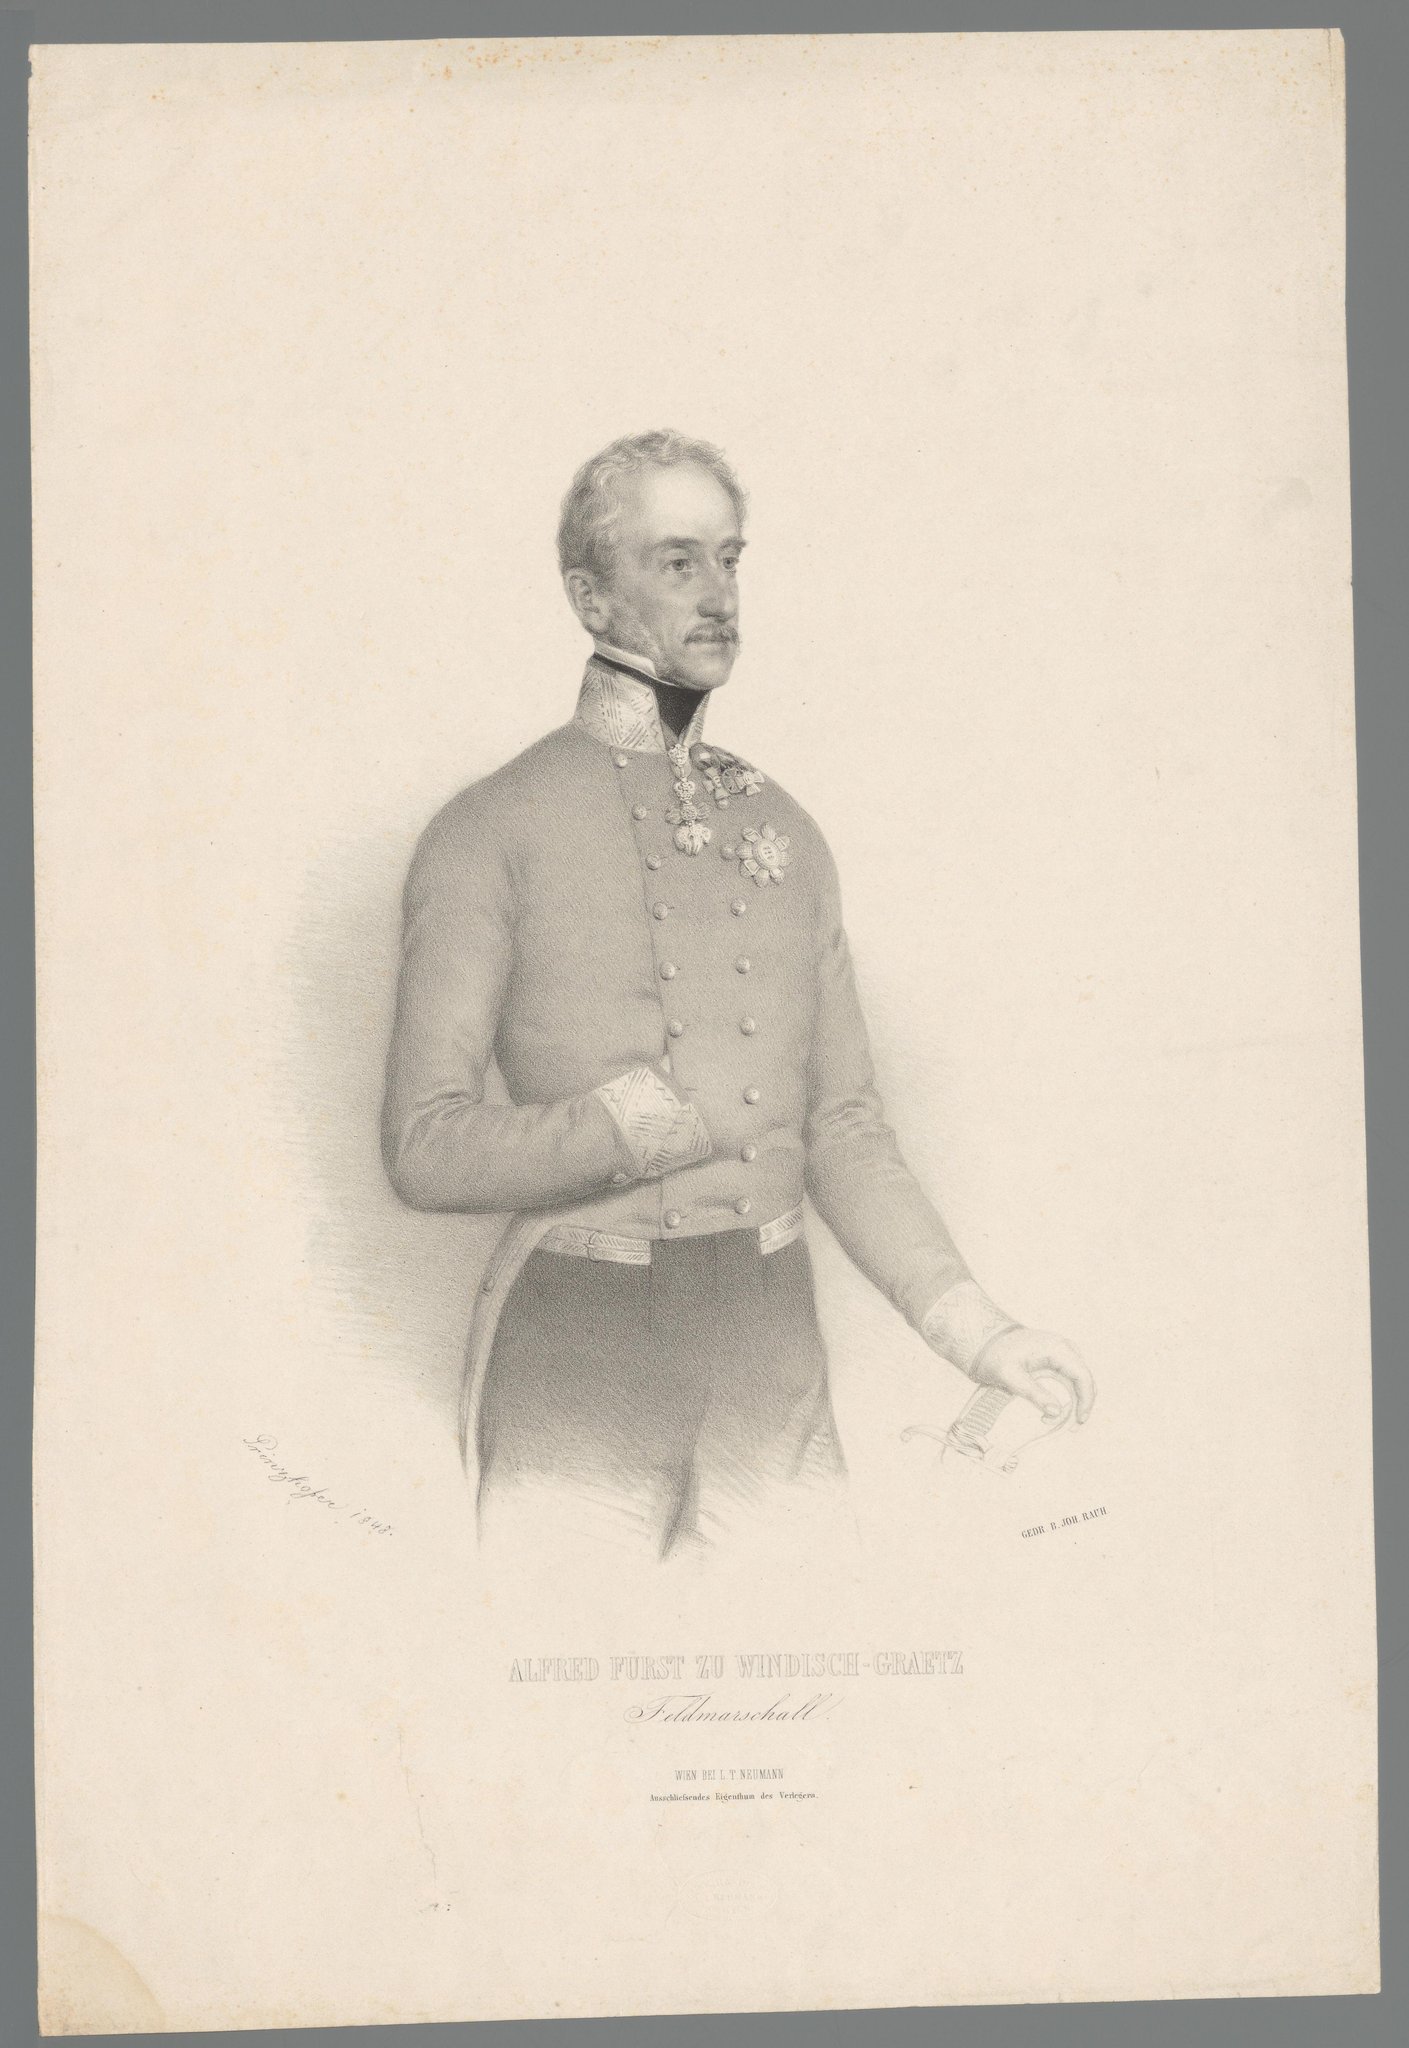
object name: print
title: Portret van Alfred I zu Windisch-Graetz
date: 1848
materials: paper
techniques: lithograph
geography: vienna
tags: brussels, vienna, commander-in-chief, general, marshal, historical persons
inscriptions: collector's mark: Lugt 2228, check stamp: ‘Kunsthandlung L.T. Neumann in Wien’